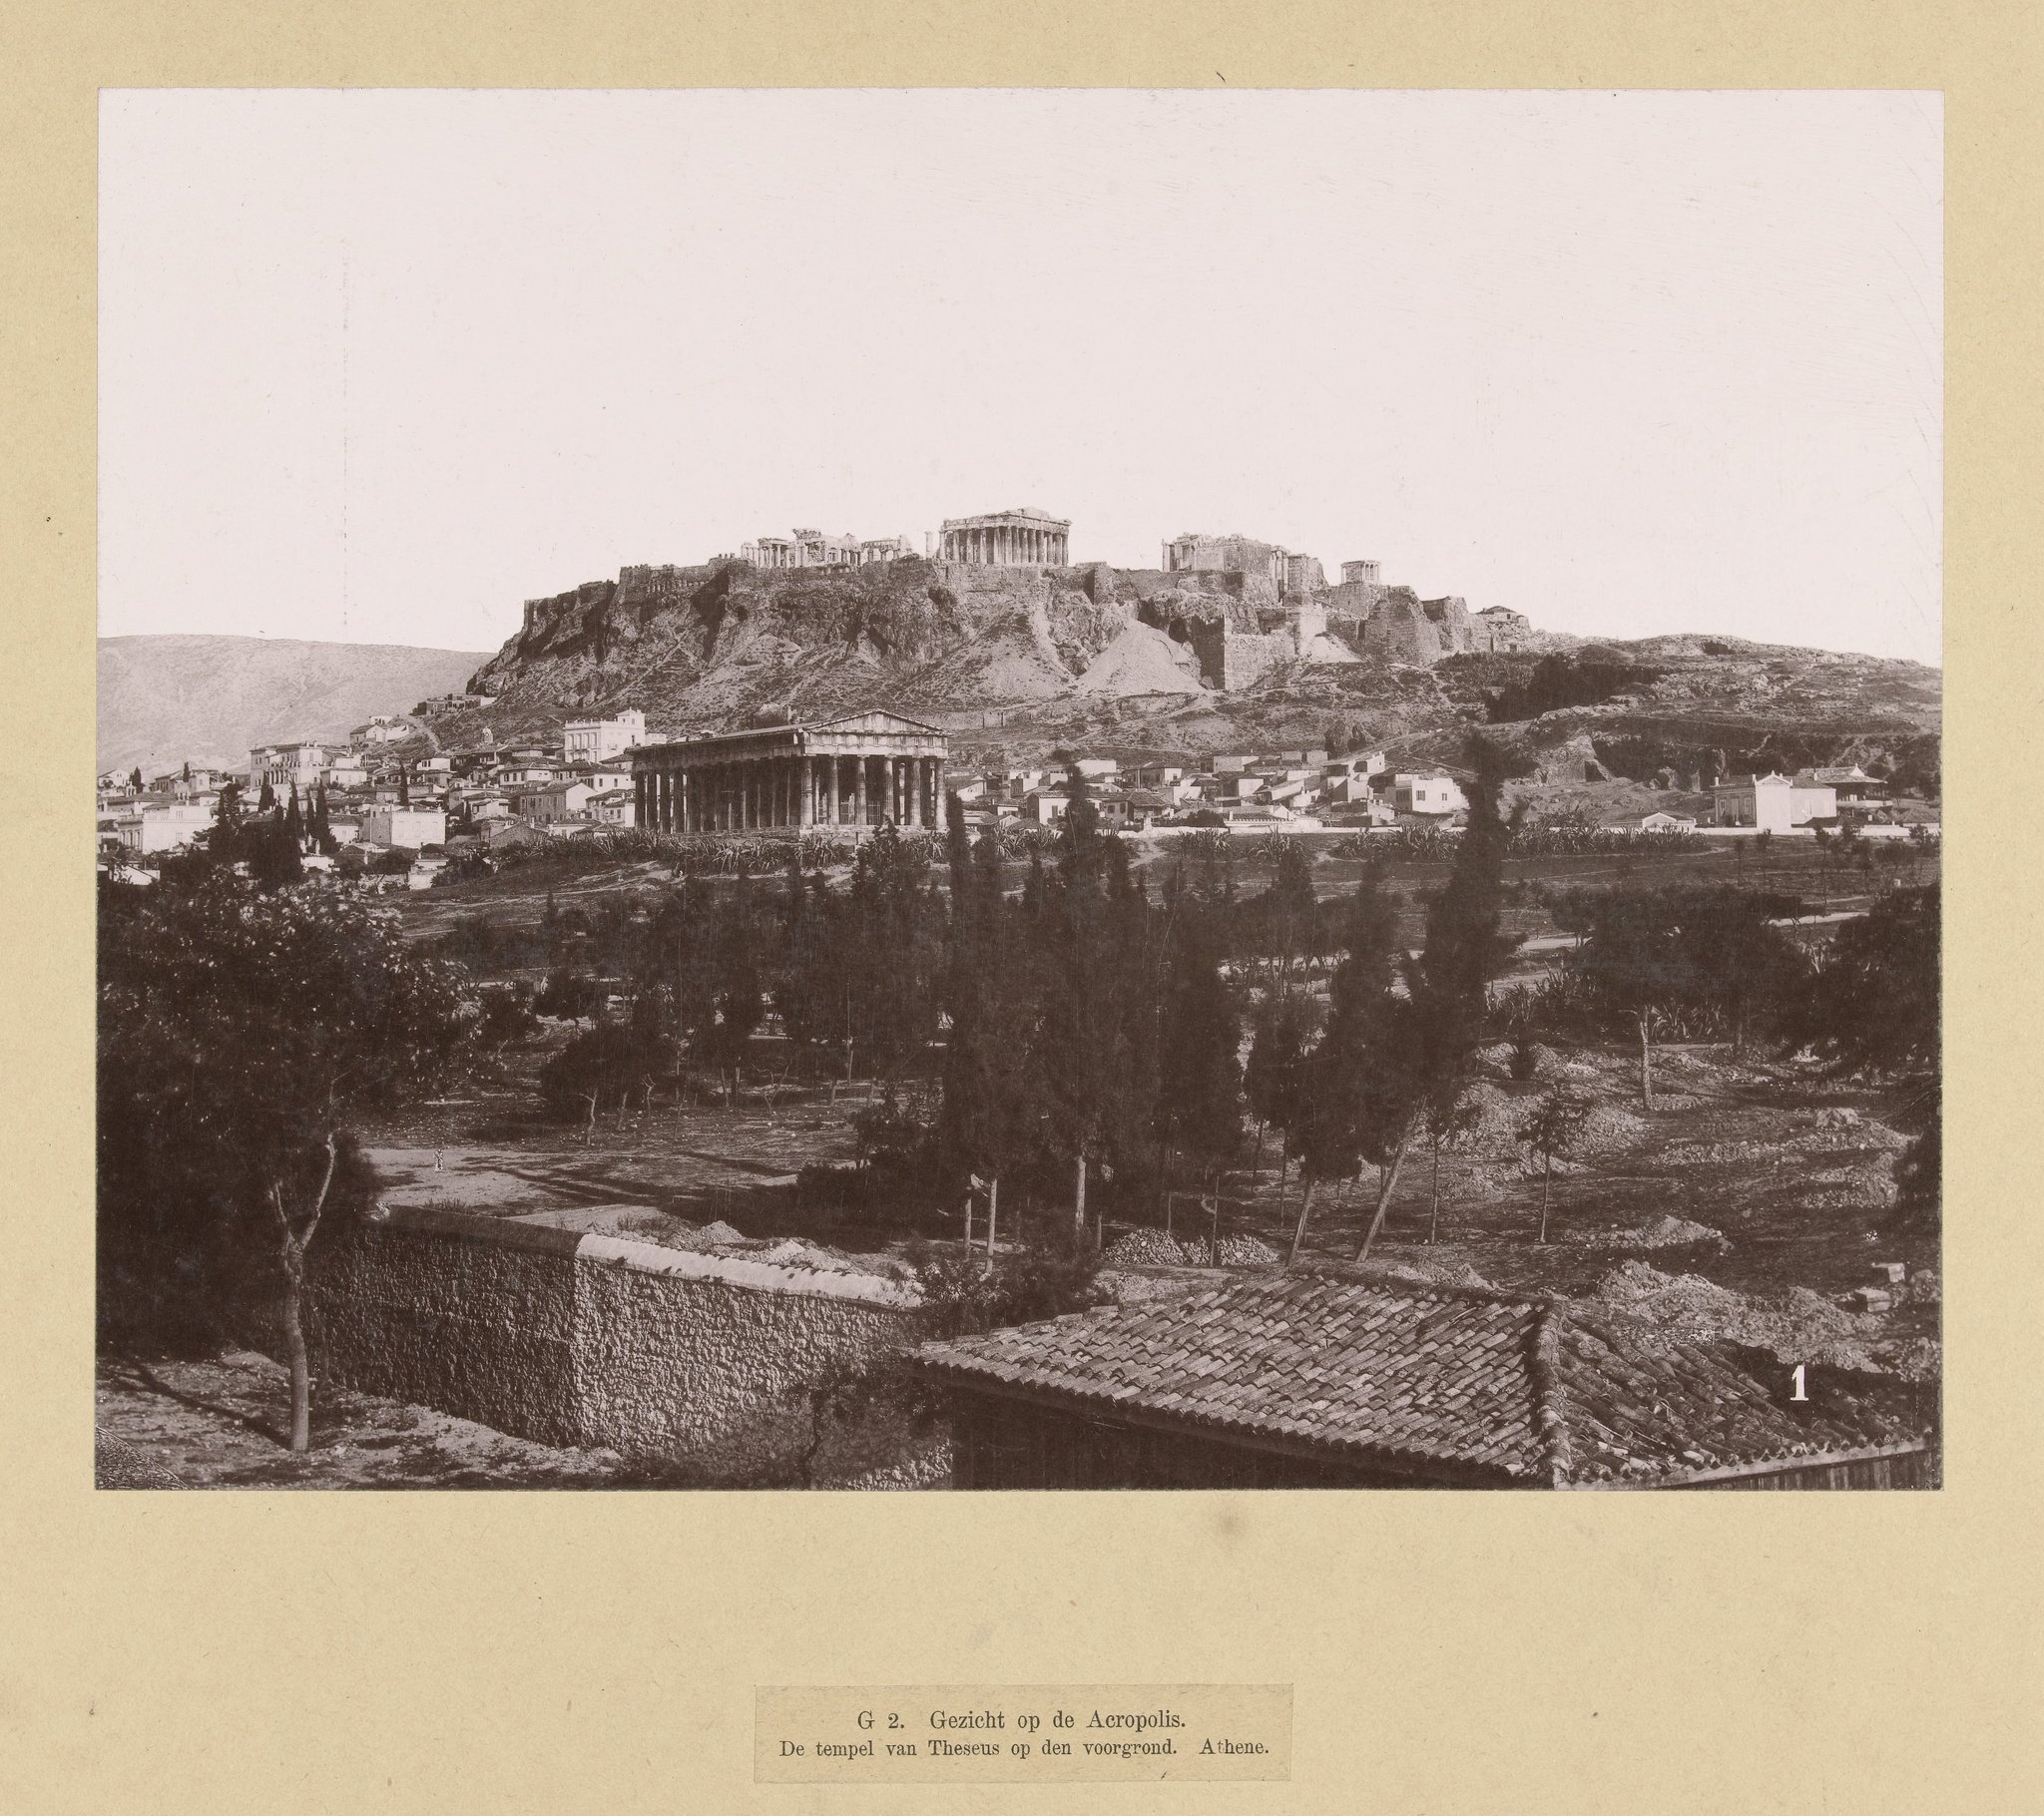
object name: photomechanical print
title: G 2. Gezicht op de Acropolis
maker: Anonymous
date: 1890-1893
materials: cardboard, paper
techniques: photograph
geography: athens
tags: ruin of a building ~ architecture, temple, shrine ~ greek religion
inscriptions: check stamp: ‘Bristol/ L.M.’, number: ‘1’, stamp: ‘Gemeentelijke b[ibliot]heek/ Rotterdam’, inscription: ‘G 2. Gezicht op de Acropolis./ De tempel van Theseus op den voorgrond. Athene’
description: Onderdeel van een groep door fotograaf Richard Polak op reis verzamelde foto’s. Deze fotomechanische afdruk is samen met andere op zijn reizen verzamelde foto's tentoongesteld bij de Rotterdamsche Kunstkring (1895), Arti en Amicitiae te Amsterdam (1897-1898?) en Societeit 't Collegie te Kampen (datum vooralsnog onbekend).